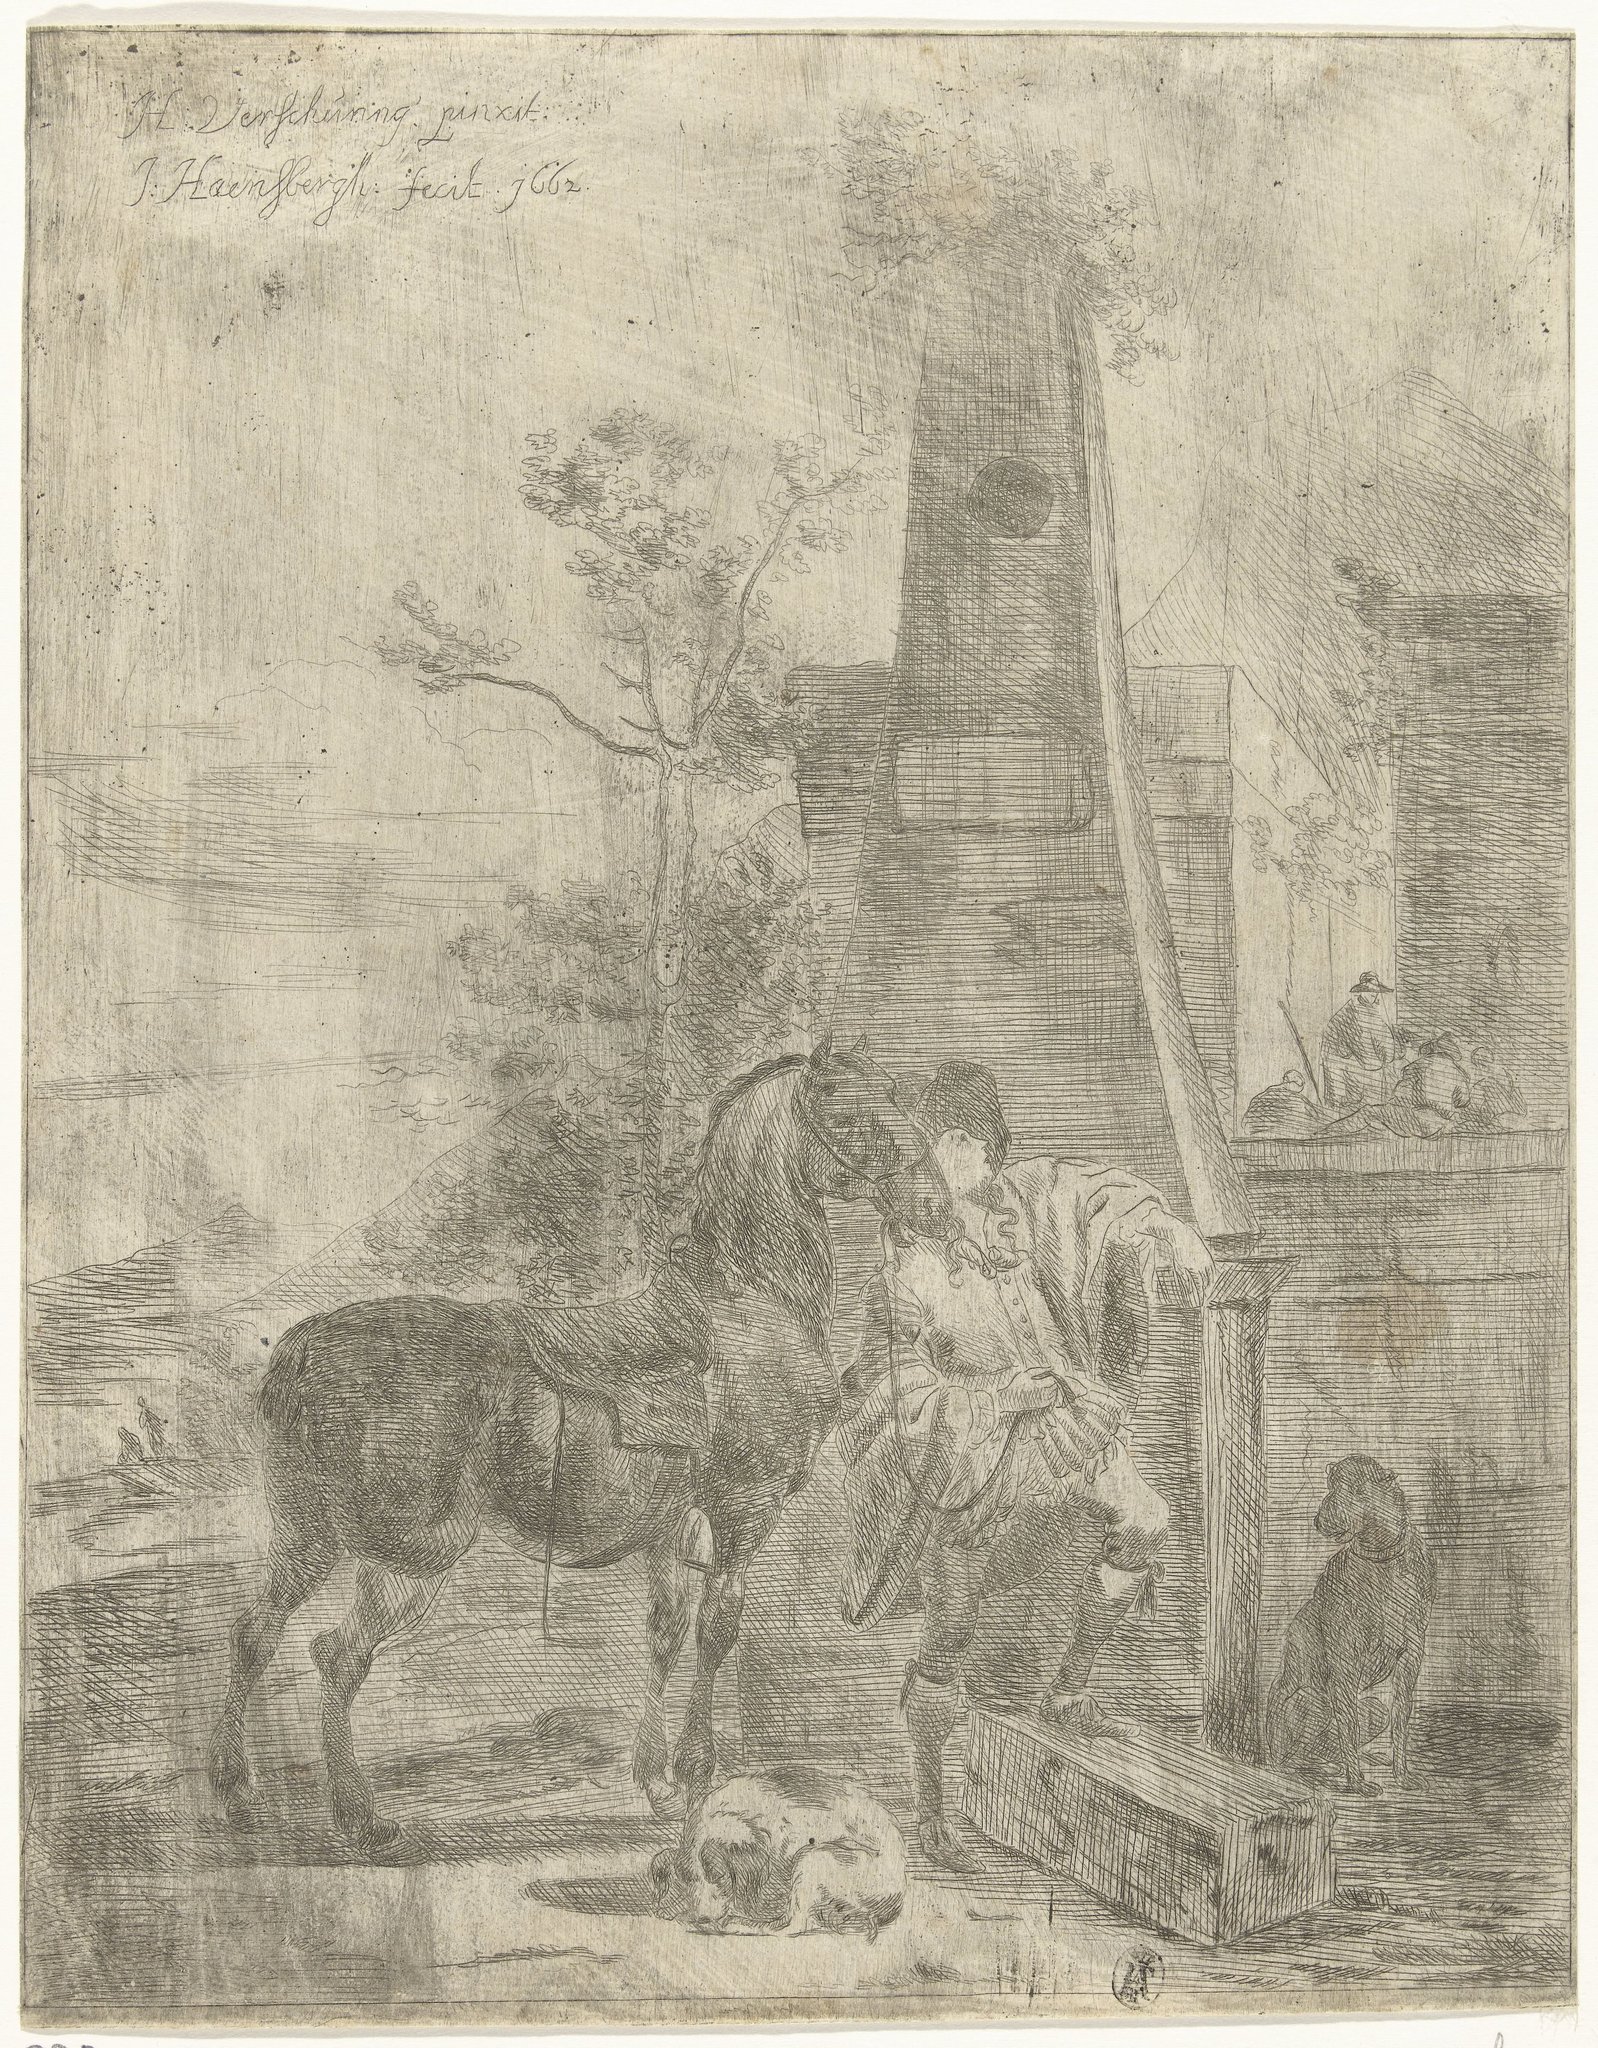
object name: print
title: Jonge man met een paard bij een monument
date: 1662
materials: paper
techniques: etching, intaglio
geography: gorinchem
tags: leading a horse by the reins; rider beside his horse, landscape with monument (+ city(-scape) with figures, staffage)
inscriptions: collector's mark: Lugt 971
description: Een jonge man met een paard aan de leidsels en twee honden bij een obelisk in een landschap.